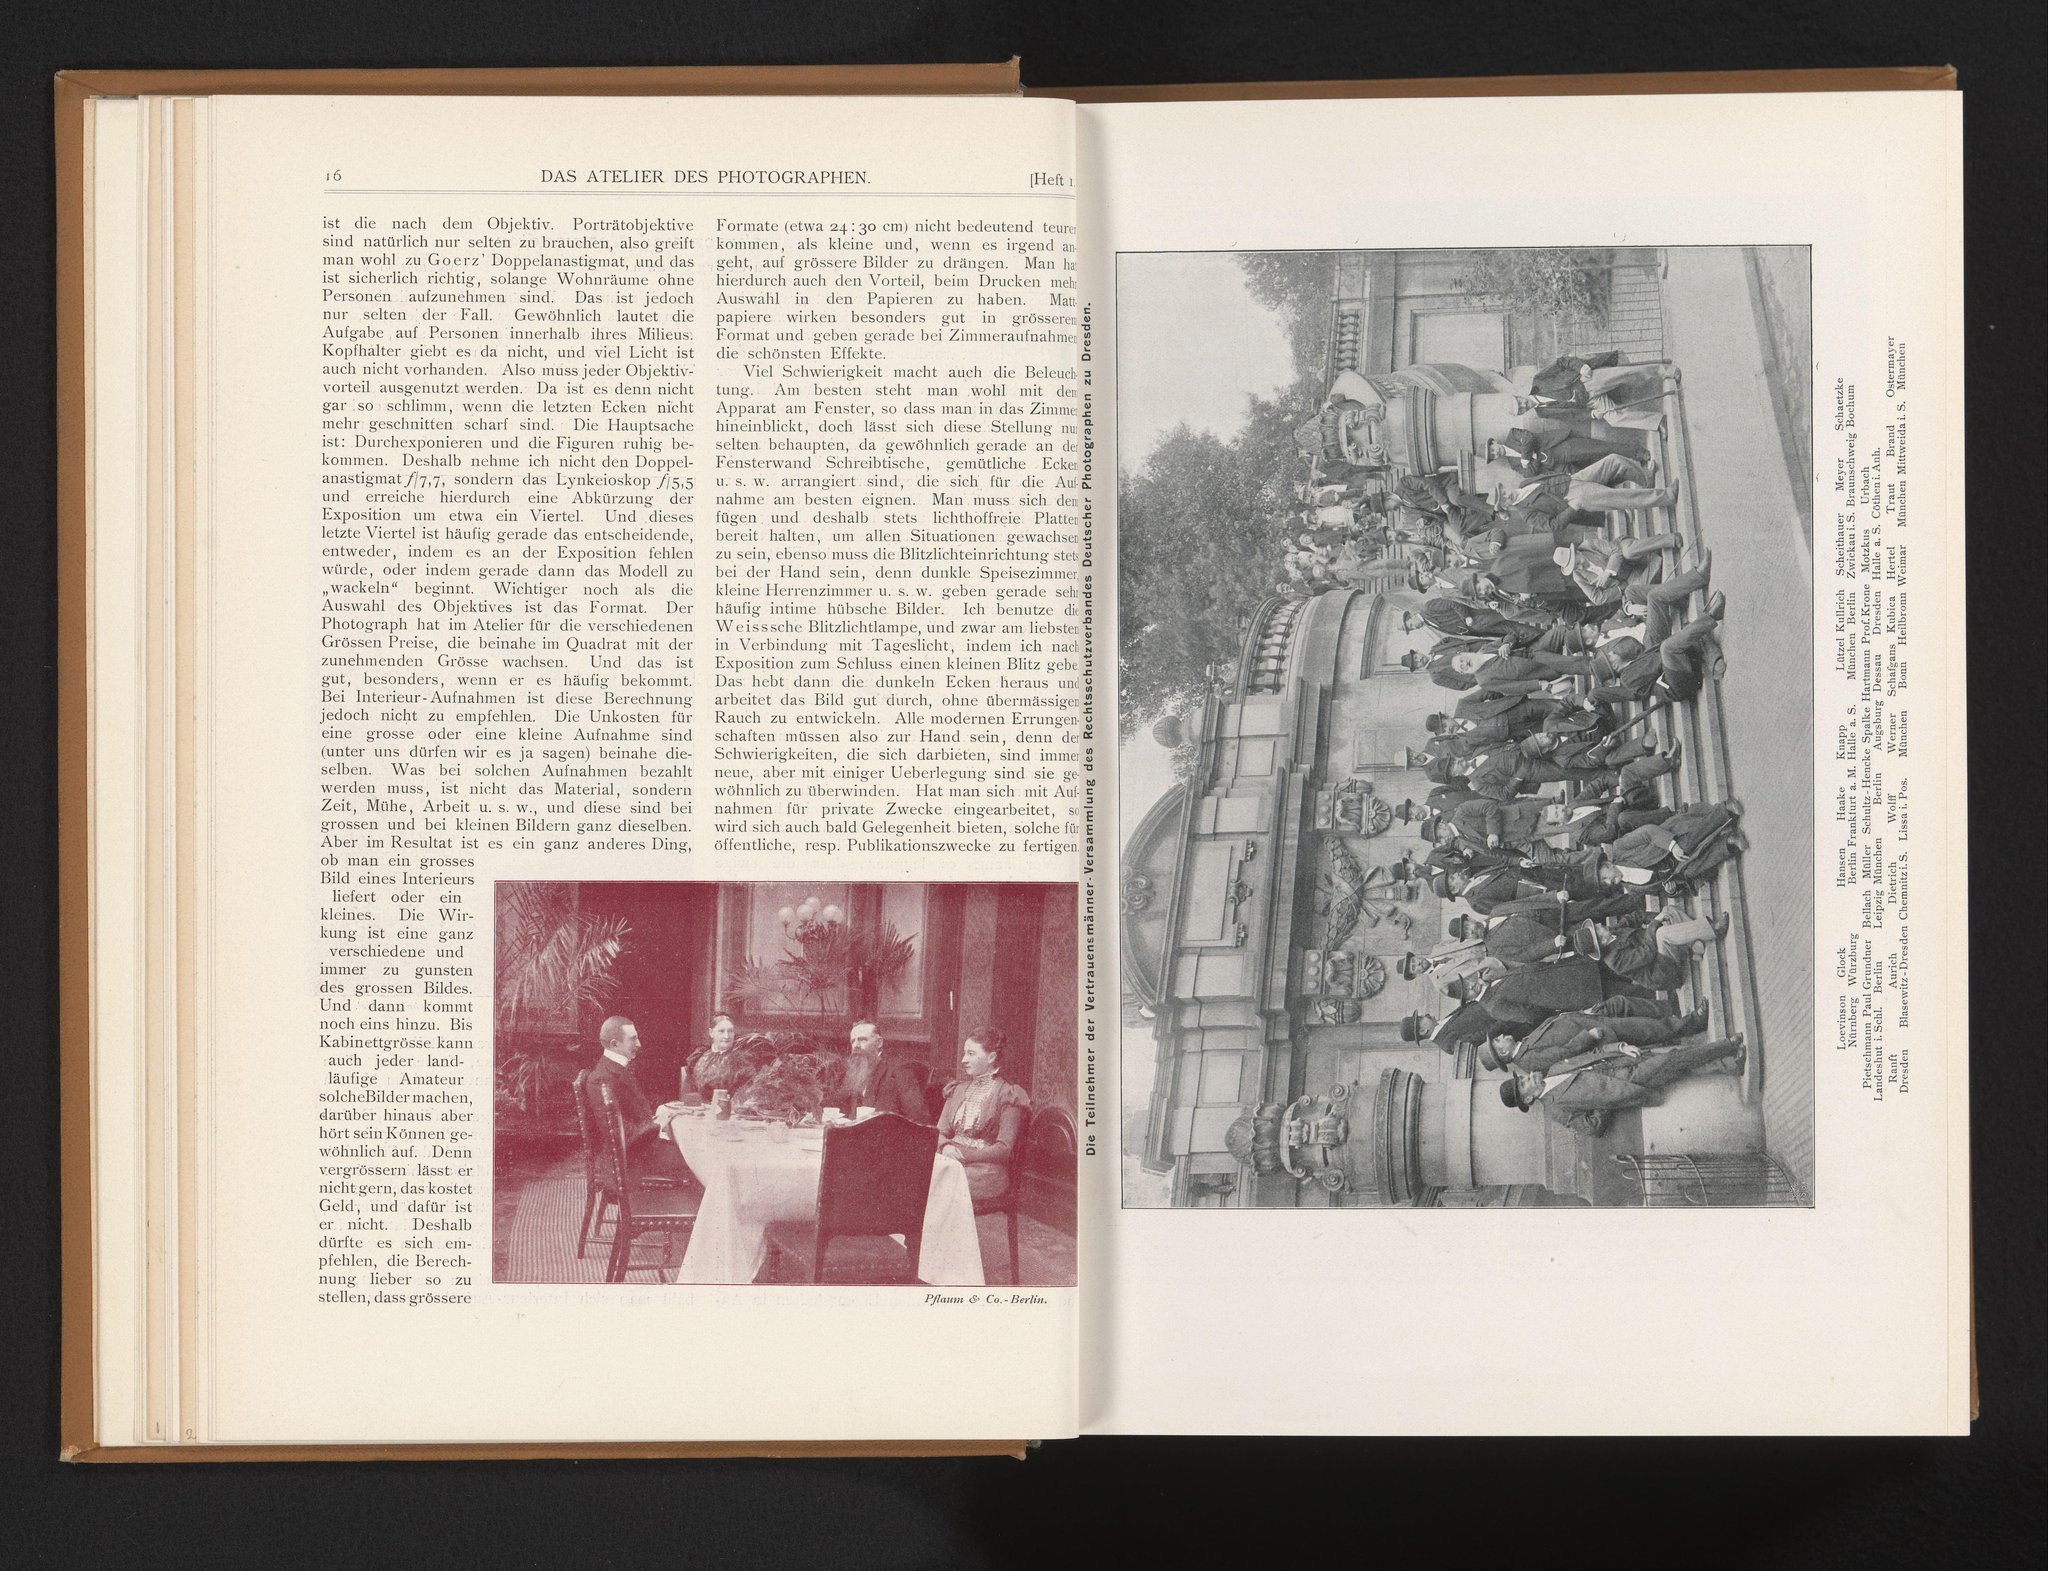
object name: photomechanical print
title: Groepsportret van de deelnemers aan een bijeenkomst voor vertrouwenspersonen van de Rechtsschutzverbandes Deutscher Photographen in Dresden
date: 1895-1900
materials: paper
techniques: autotype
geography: leipzig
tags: anonymous historical persons portrayed in a group, in a group-portrait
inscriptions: monogram: ‘LEIPZIG/ S G’, name: ‘Loevinson/ Nürnberg/ Glock/ Würzburg (...) Brand/ Mittweida i. S./ Ostermayer/ München’